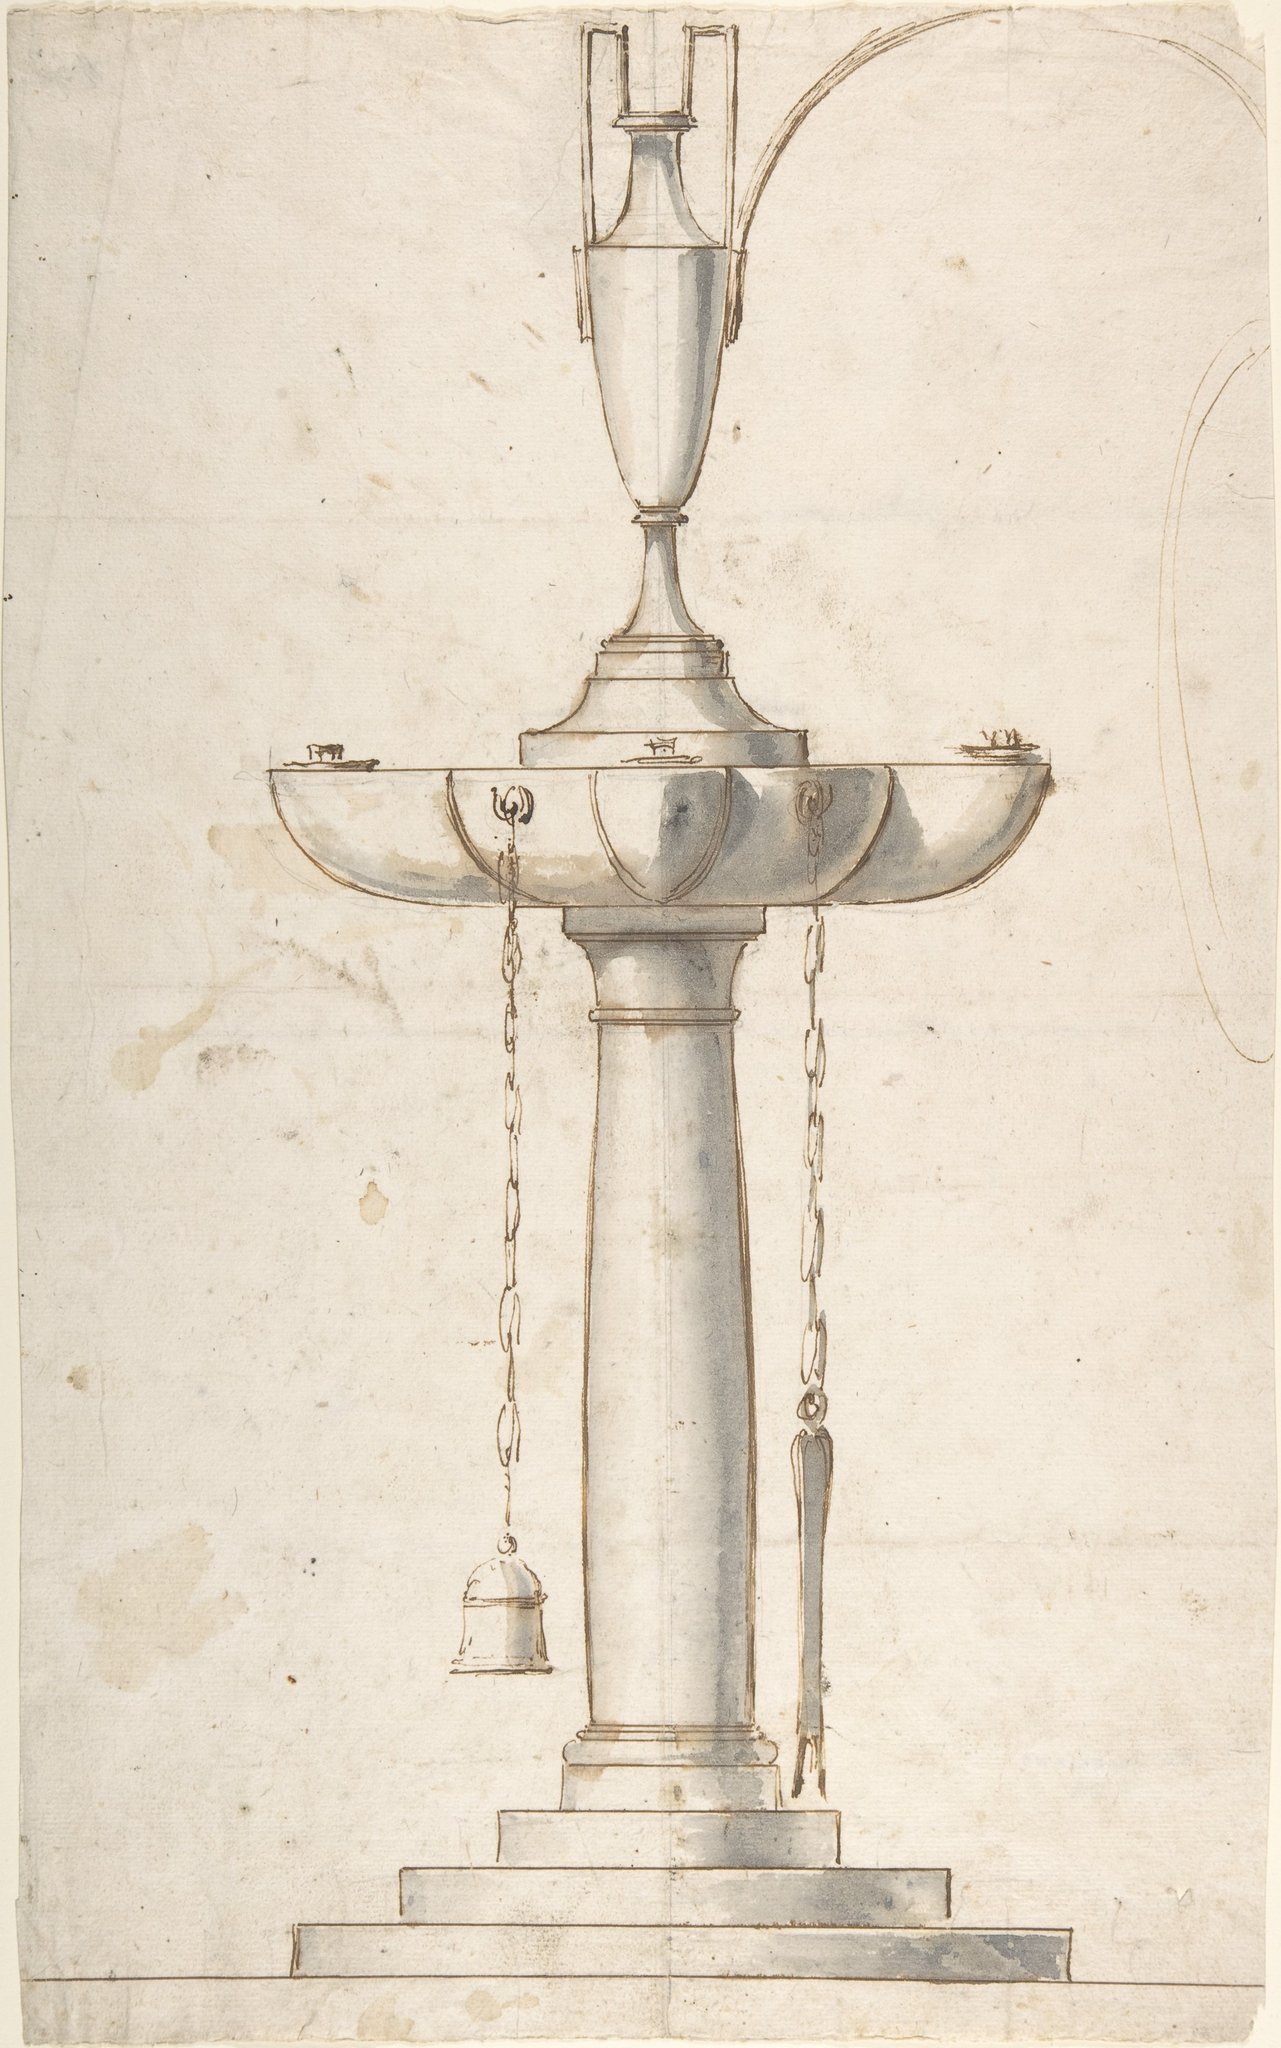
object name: drawing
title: Lamp with Four Wicks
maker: anonymous, italian, 19th century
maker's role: artist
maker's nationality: italian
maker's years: 1800-1900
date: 1801-1900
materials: ink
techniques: pen, wash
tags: lamps